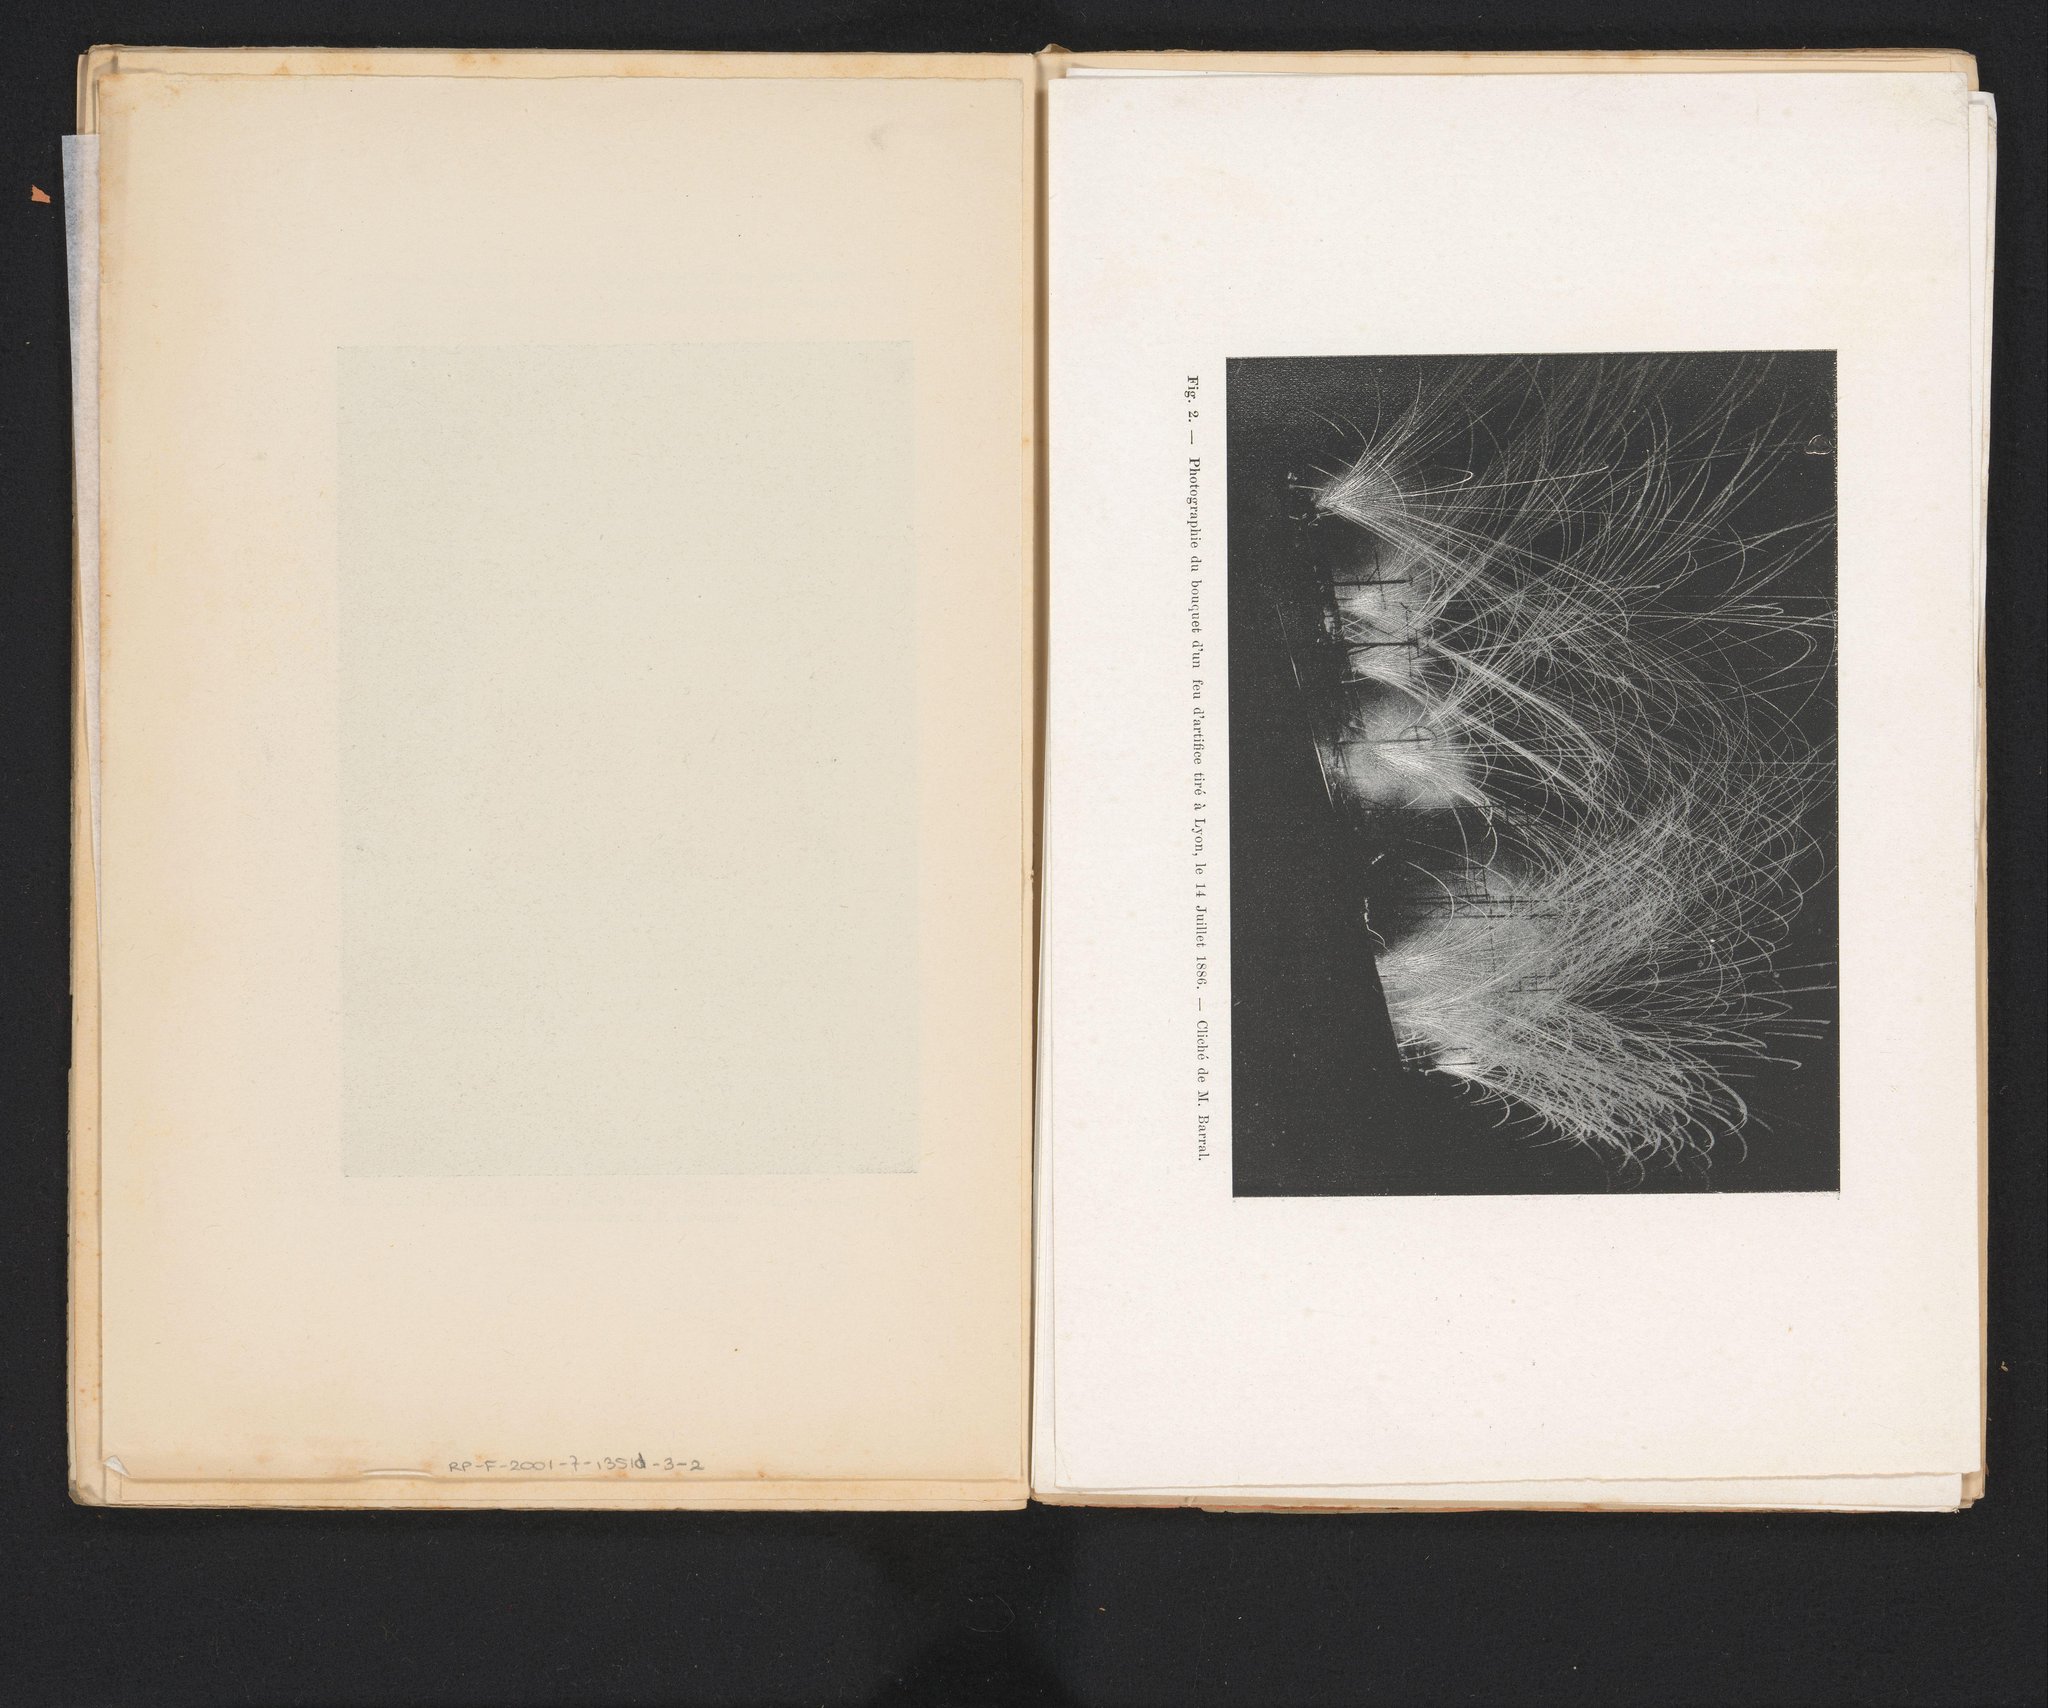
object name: photomechanical print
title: Vuurwerk in Lyon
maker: Anonymous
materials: paper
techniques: collo-autotype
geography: lyon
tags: bonfire, fire-works, lyon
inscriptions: inscription: ‘Fig. 2. - Photographie du bouquet d'un feu d'artifice tiré à Lyon, le 14 Juillet 1886. - Cliché de M. Barral.’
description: Prent op plaat los in boek tussen pagina 134 en 135.